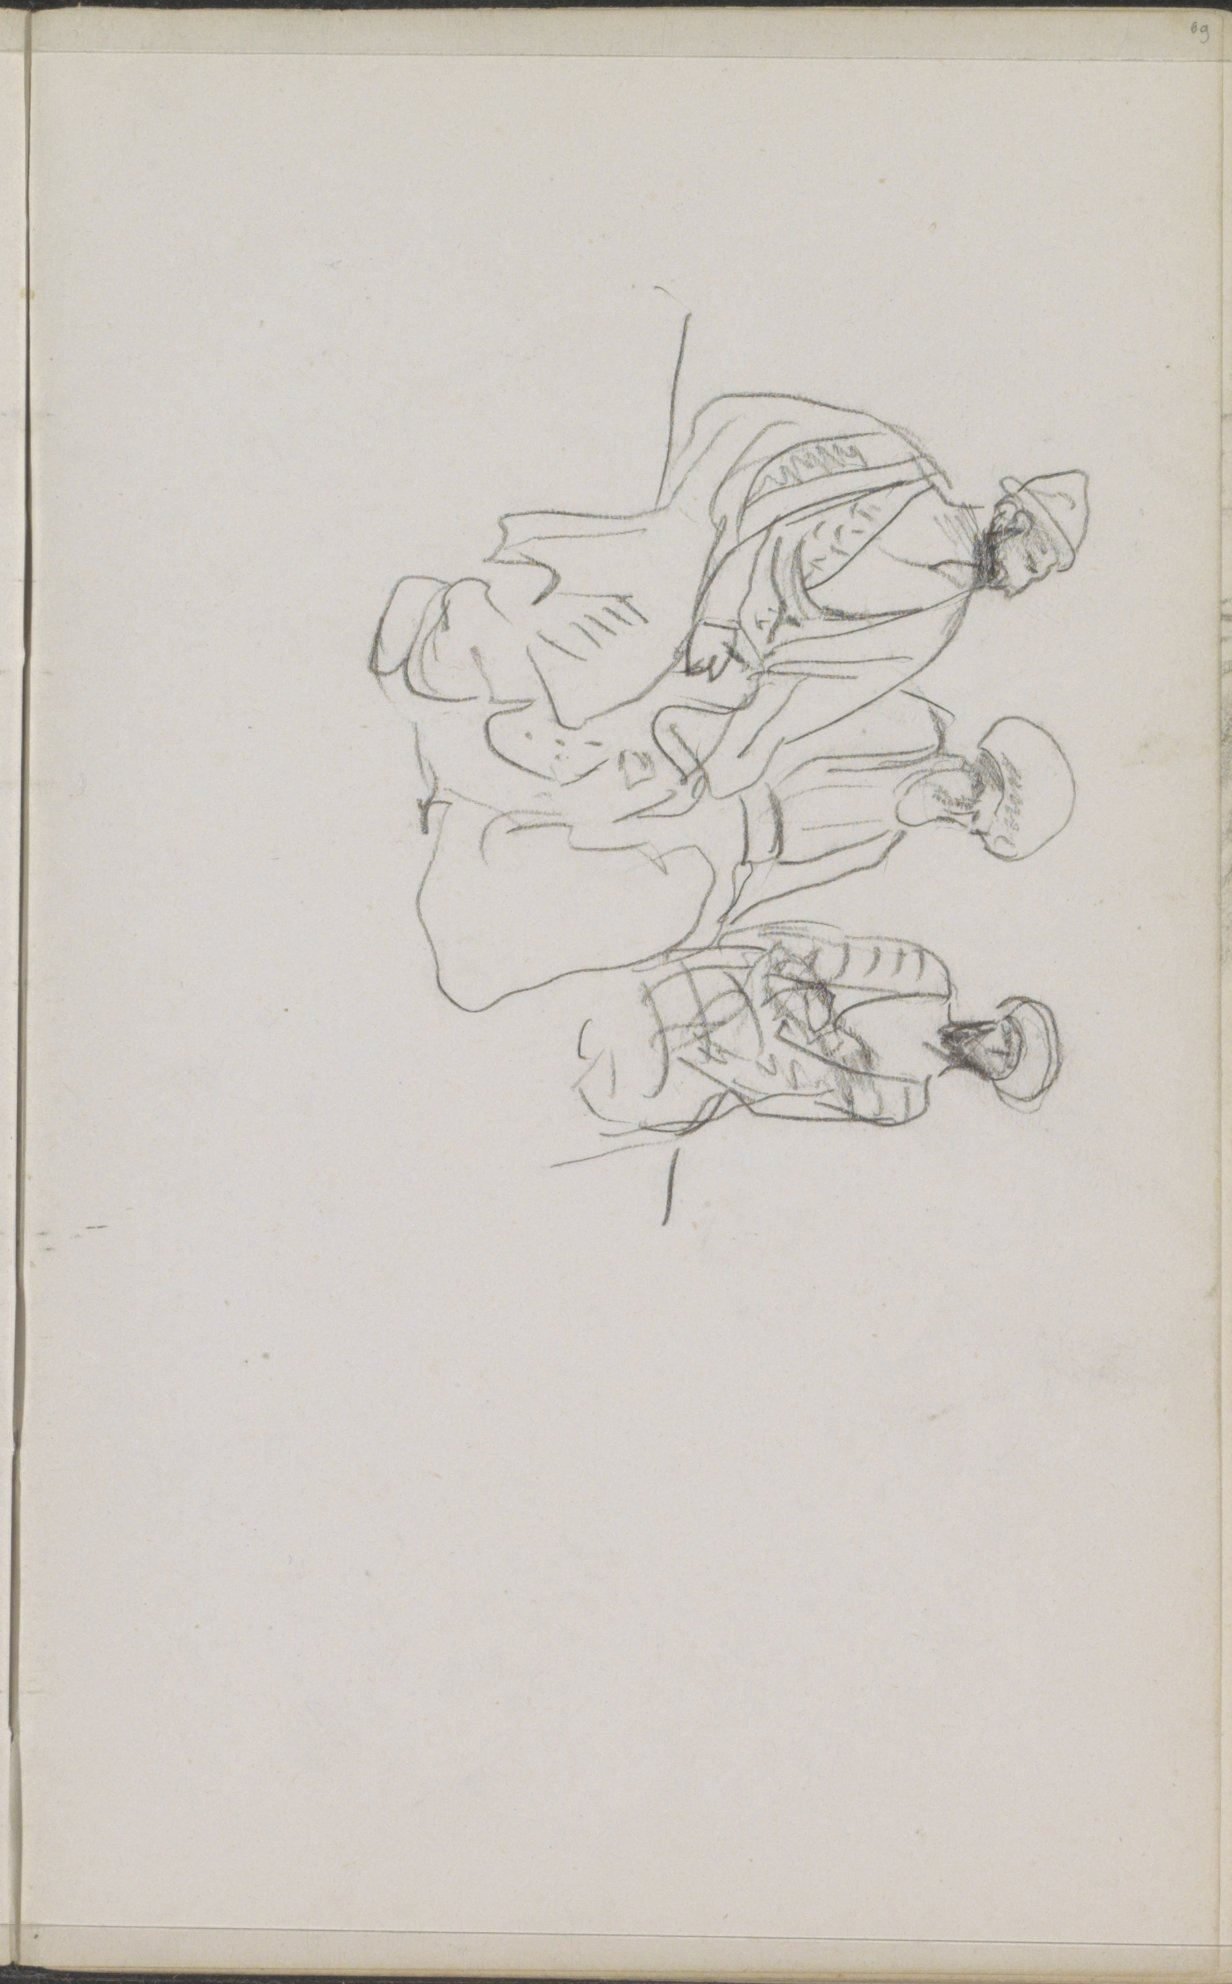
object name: sketchbook leaf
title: Drie zittende mannen in oosterse kleding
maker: marius bauer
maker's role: draughtsman, print maker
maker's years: 1867-1932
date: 1896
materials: chalk, paper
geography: turkey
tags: asiatic races and peoples, sitting figure, head-gear: turban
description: Pagina 69 uit een schetsboek met 53 bladen.